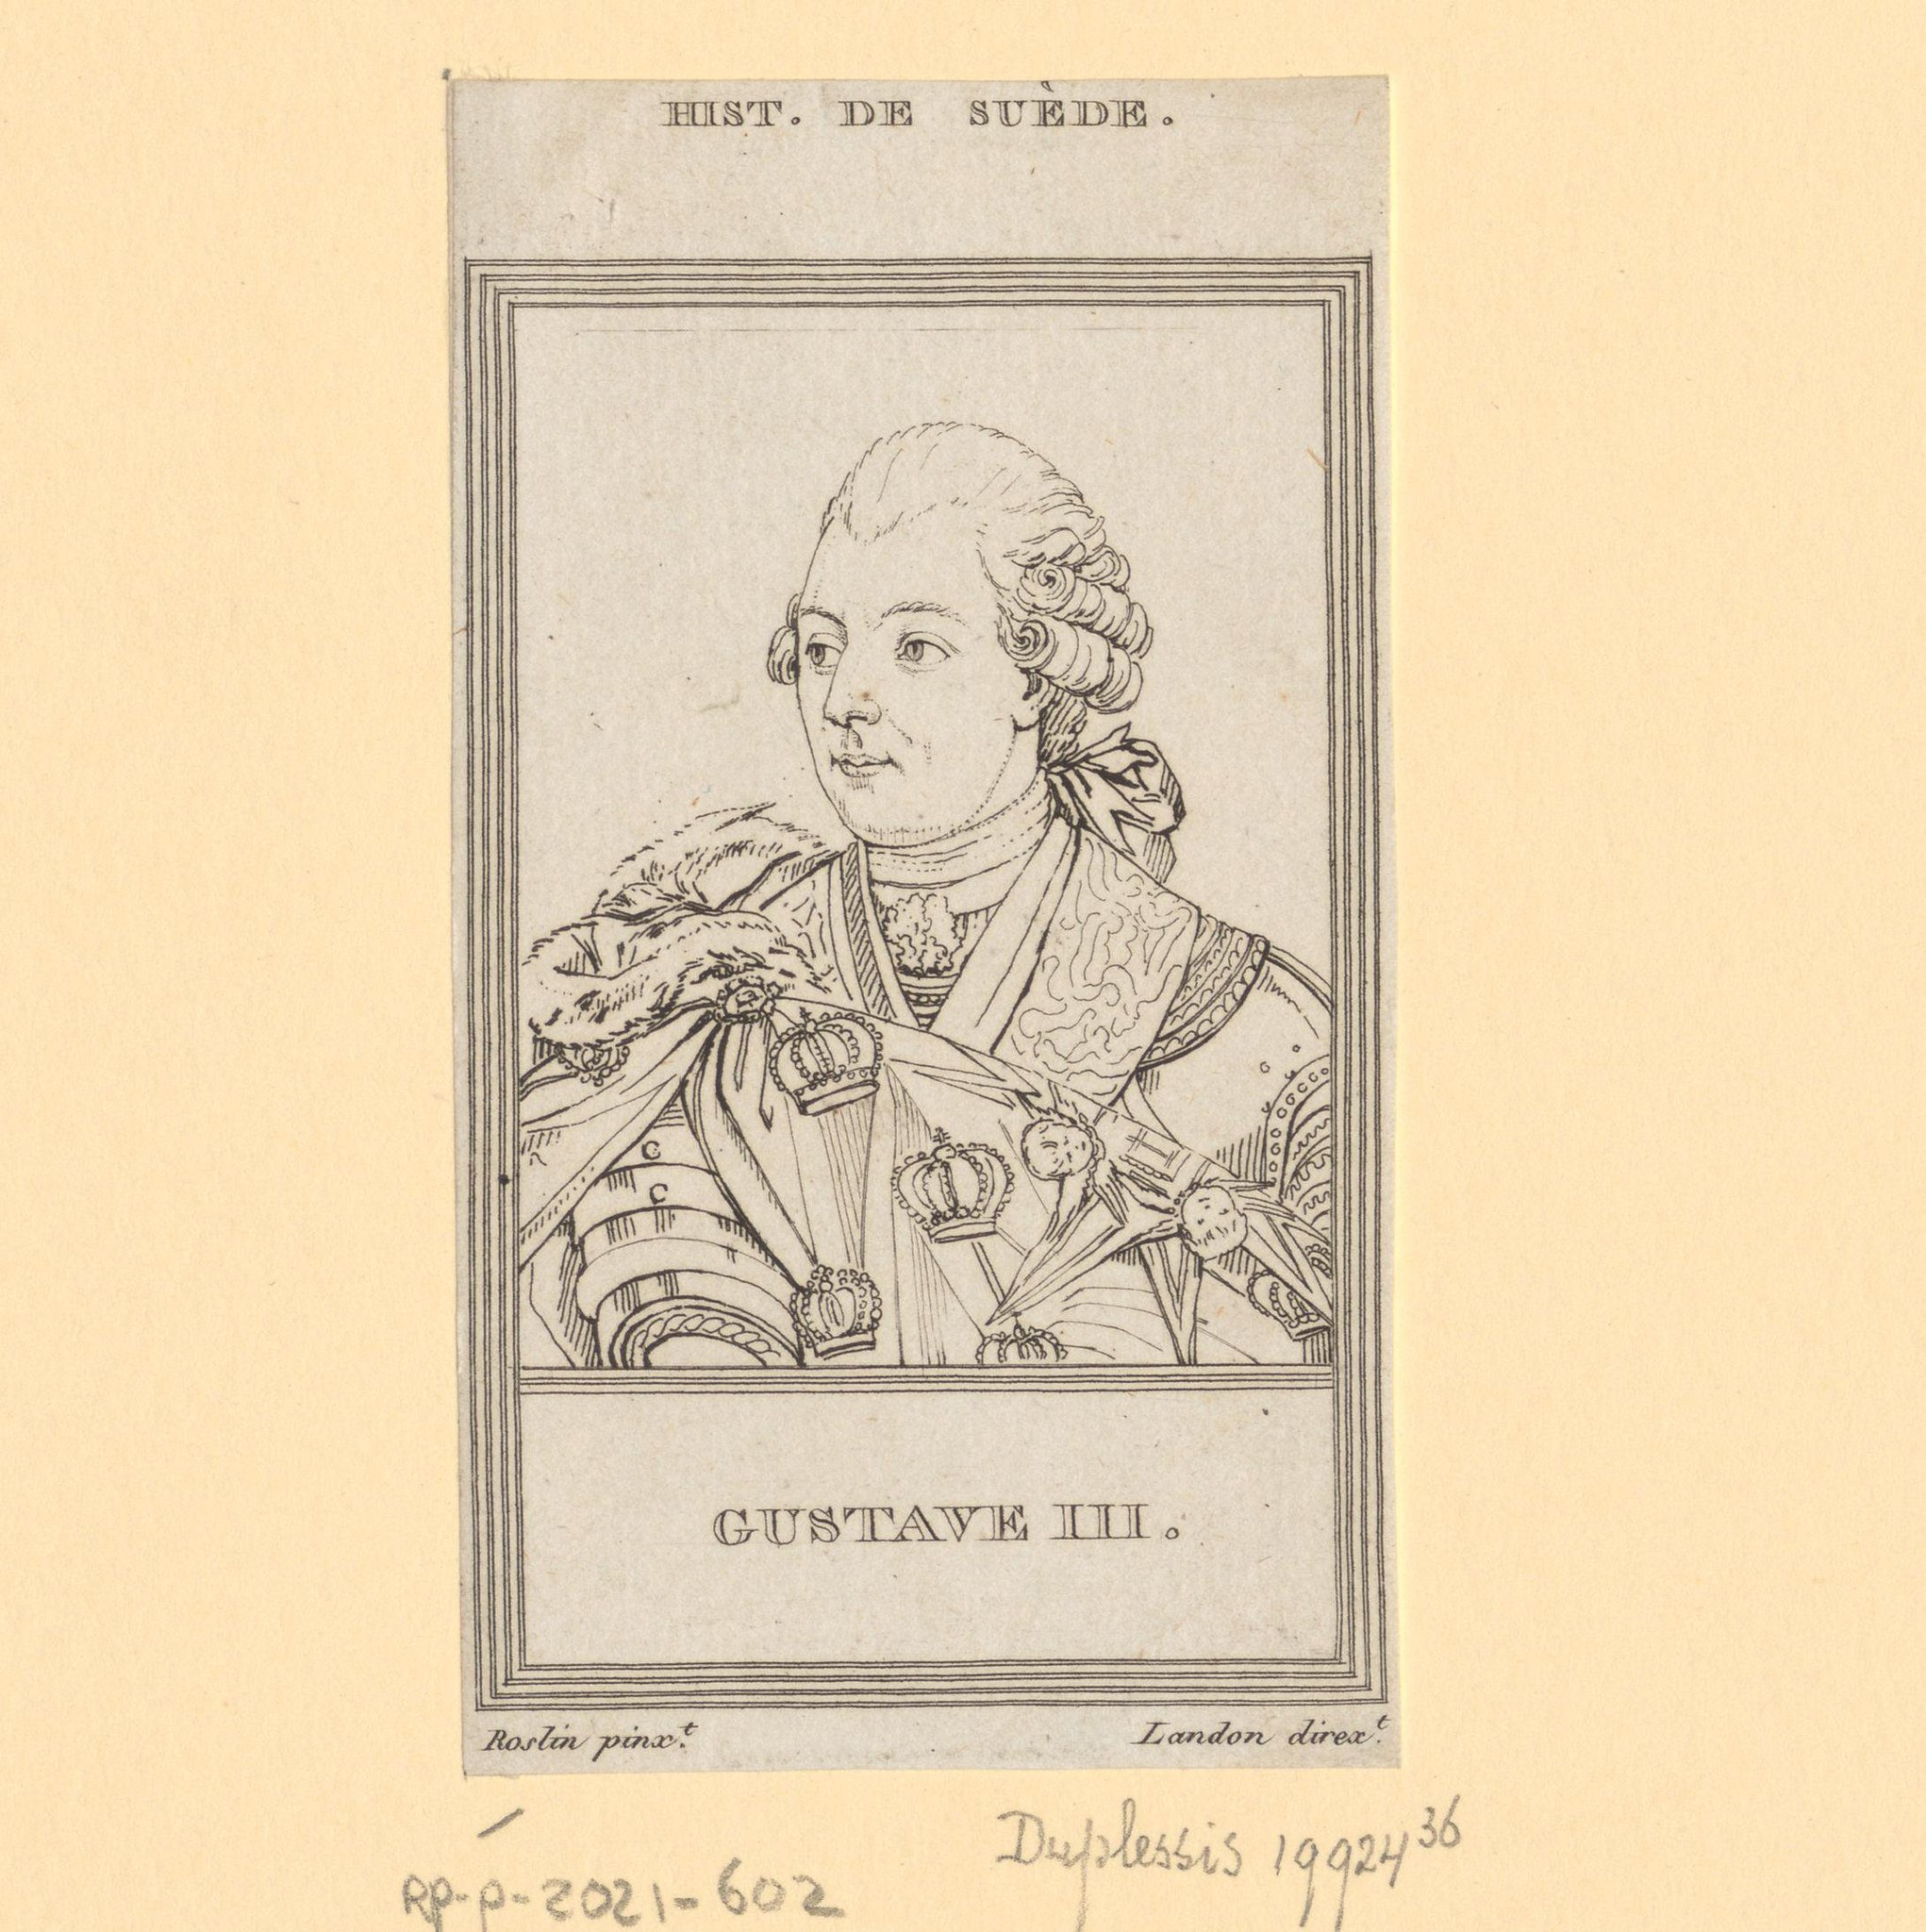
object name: print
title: Portret van Gustaaf III, koning van Zweden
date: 1805-1811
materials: paper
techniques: engraving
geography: paris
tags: historical persons, memorial medal, king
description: Prent uit: Galerie historique des hommes les plus célèbres (...). Parijs: Charles Paul Landon, 1805-1811.